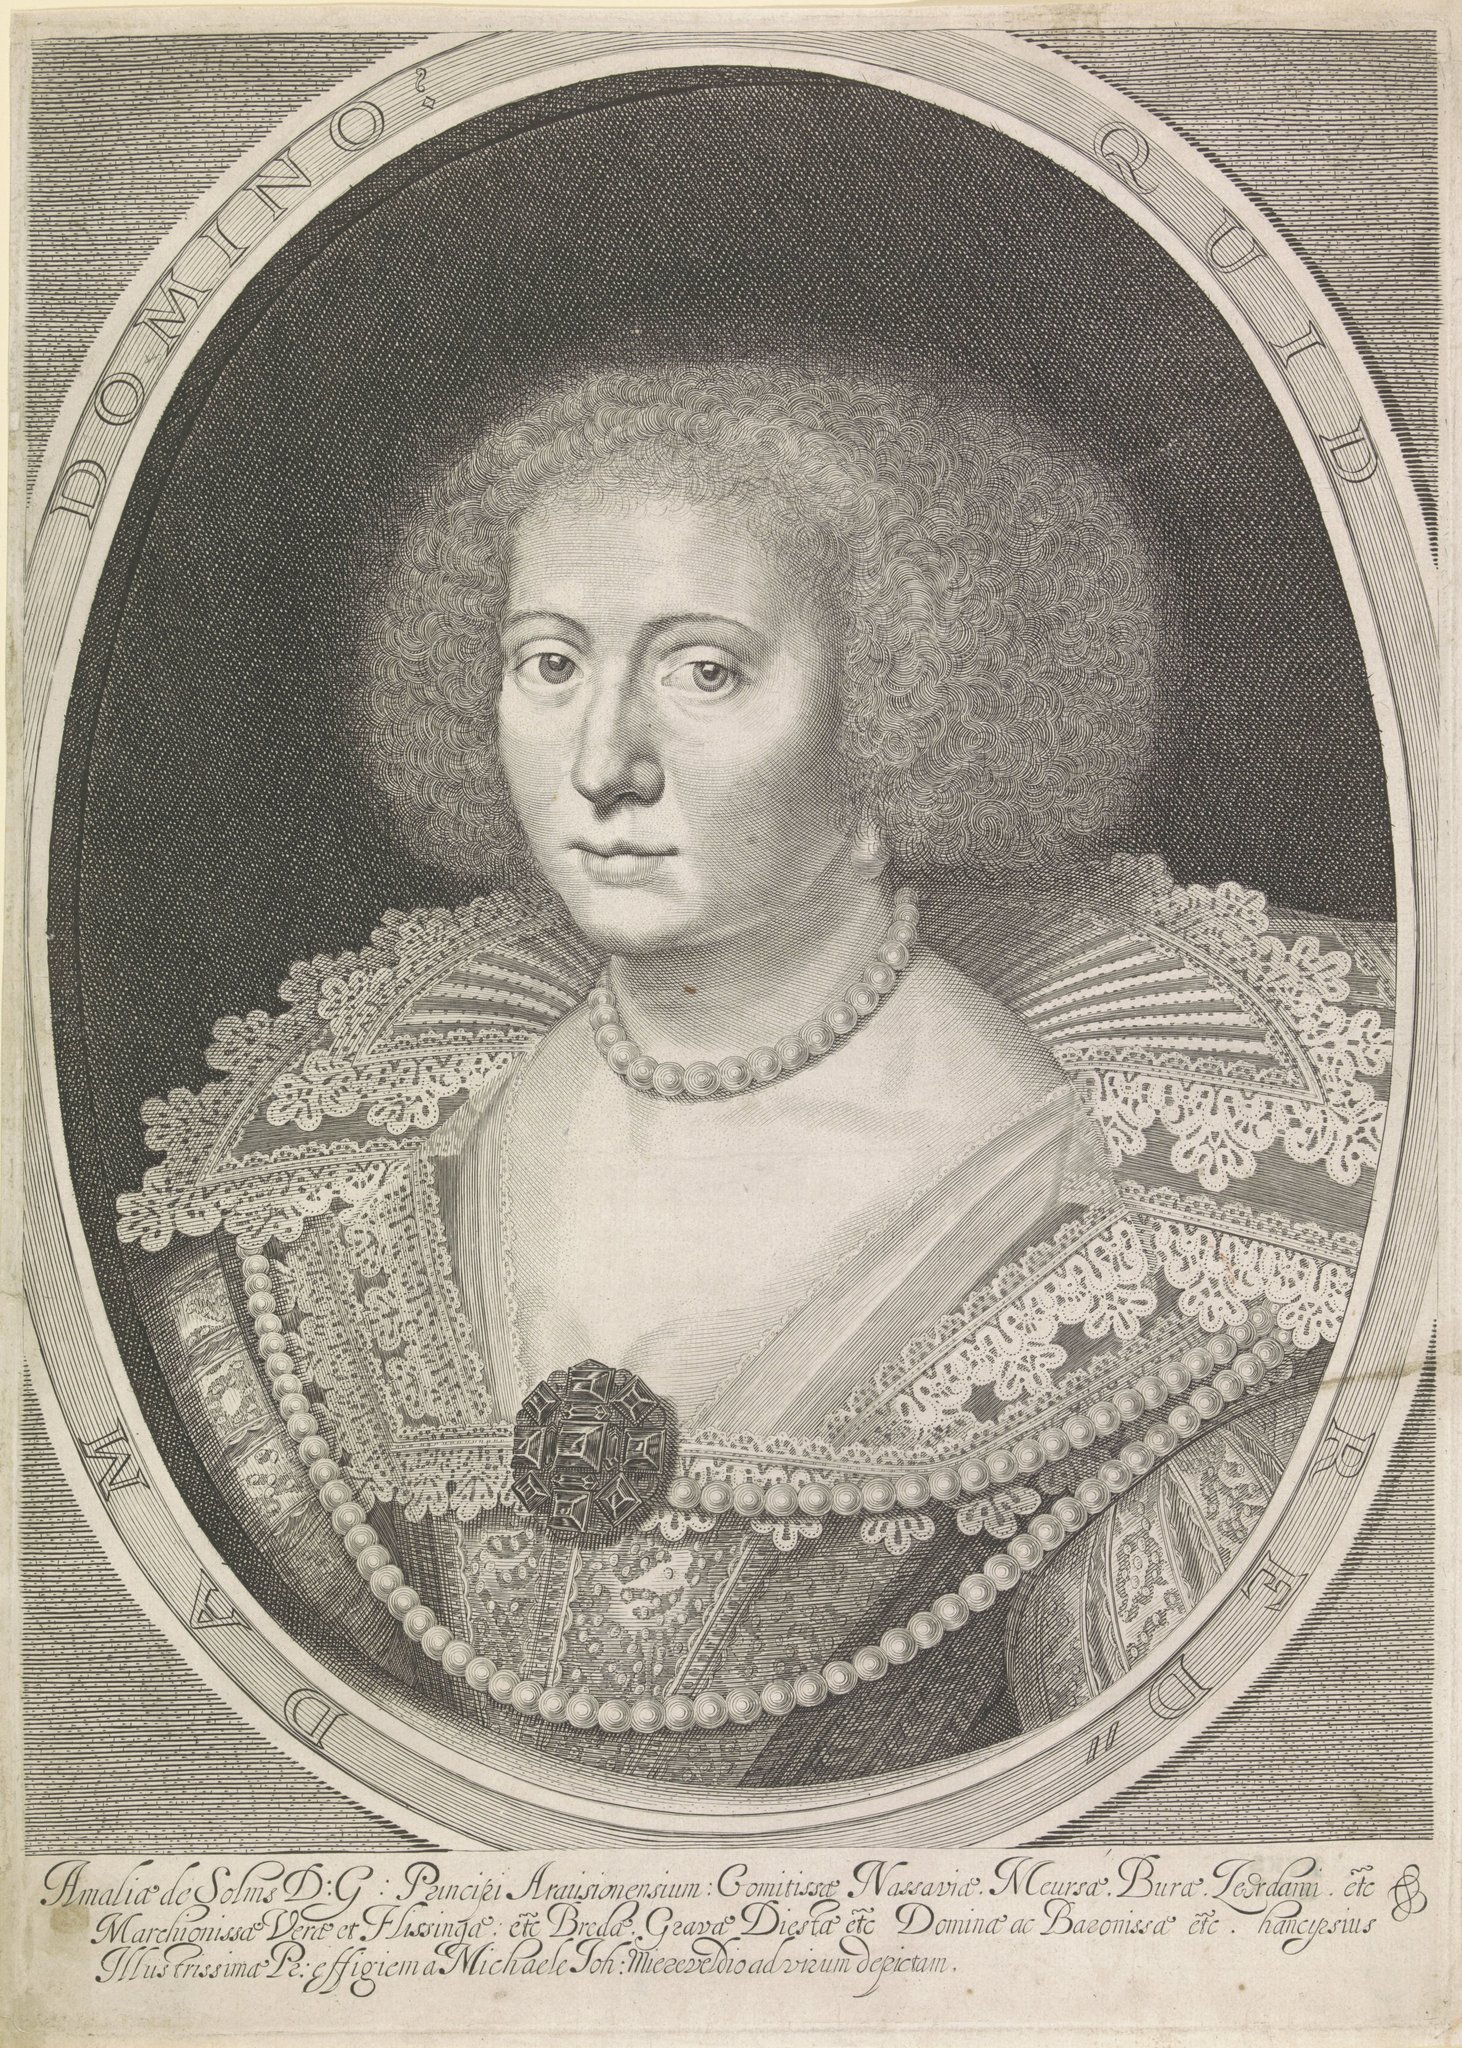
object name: print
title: Portret van Amalia van Solms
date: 1629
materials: paper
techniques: engraving, etching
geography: low countries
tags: the hague, amalia of solms-braunfels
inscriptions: collector's mark: Lugt 963, collector's mark: Lugt 2165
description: Portret van Amalia in een ovaal met randschrift. In de ondermarge drie regels Latijnse tekst.